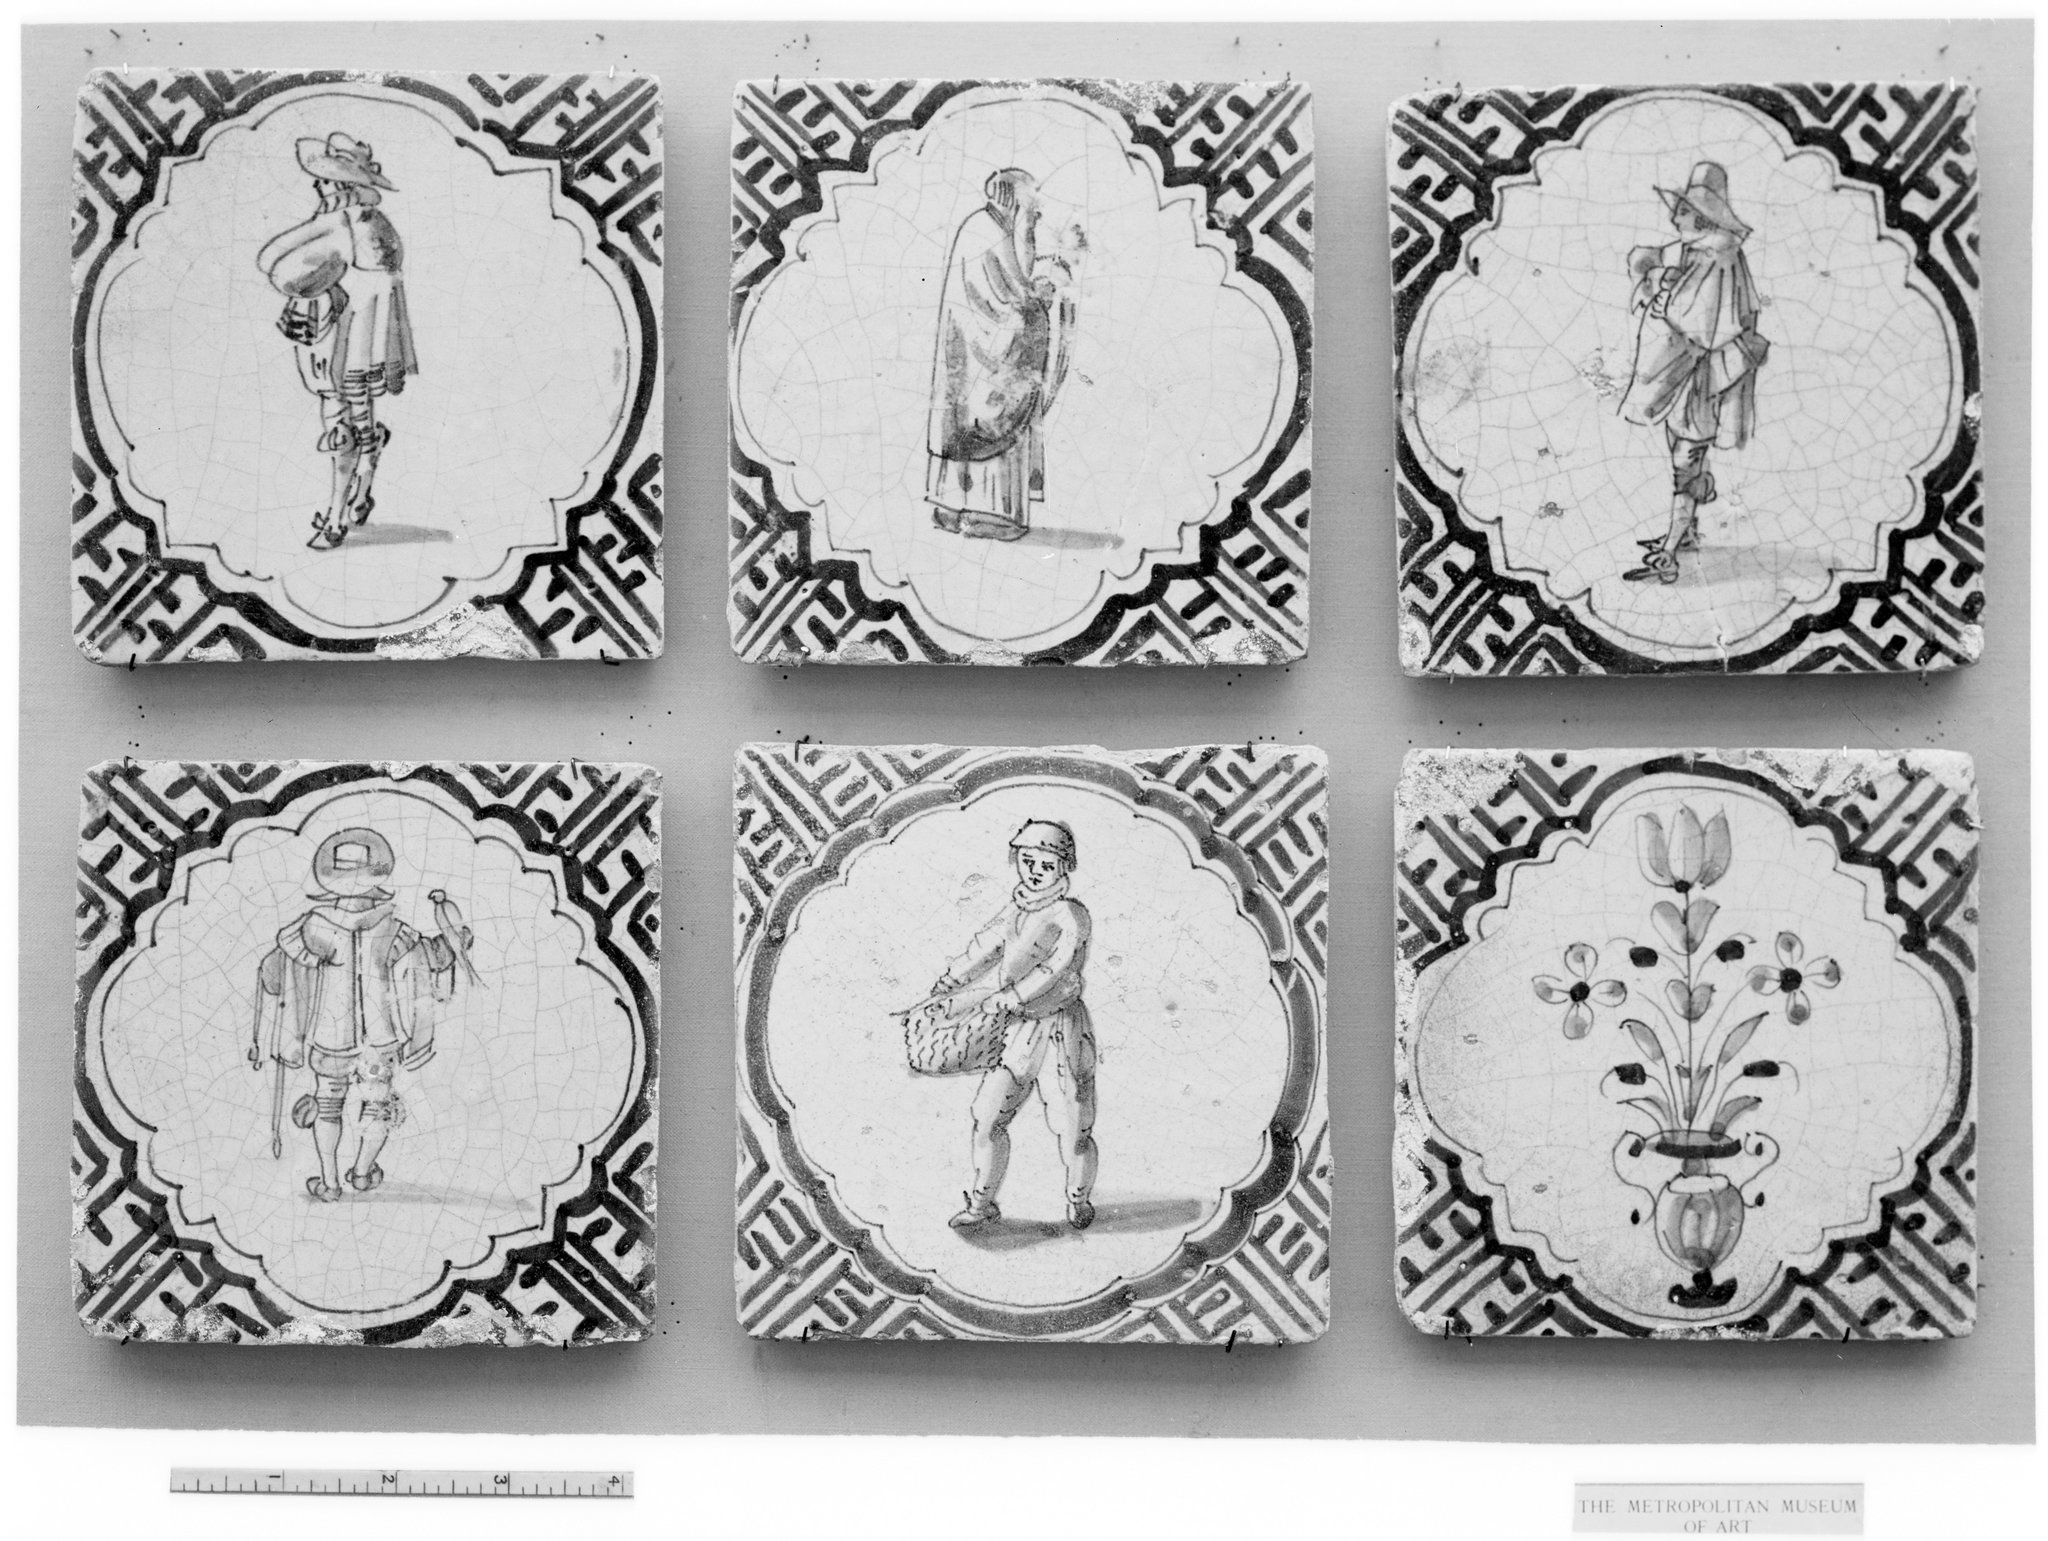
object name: tile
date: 1601-1700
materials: earthenware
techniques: glazing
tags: men,flowers